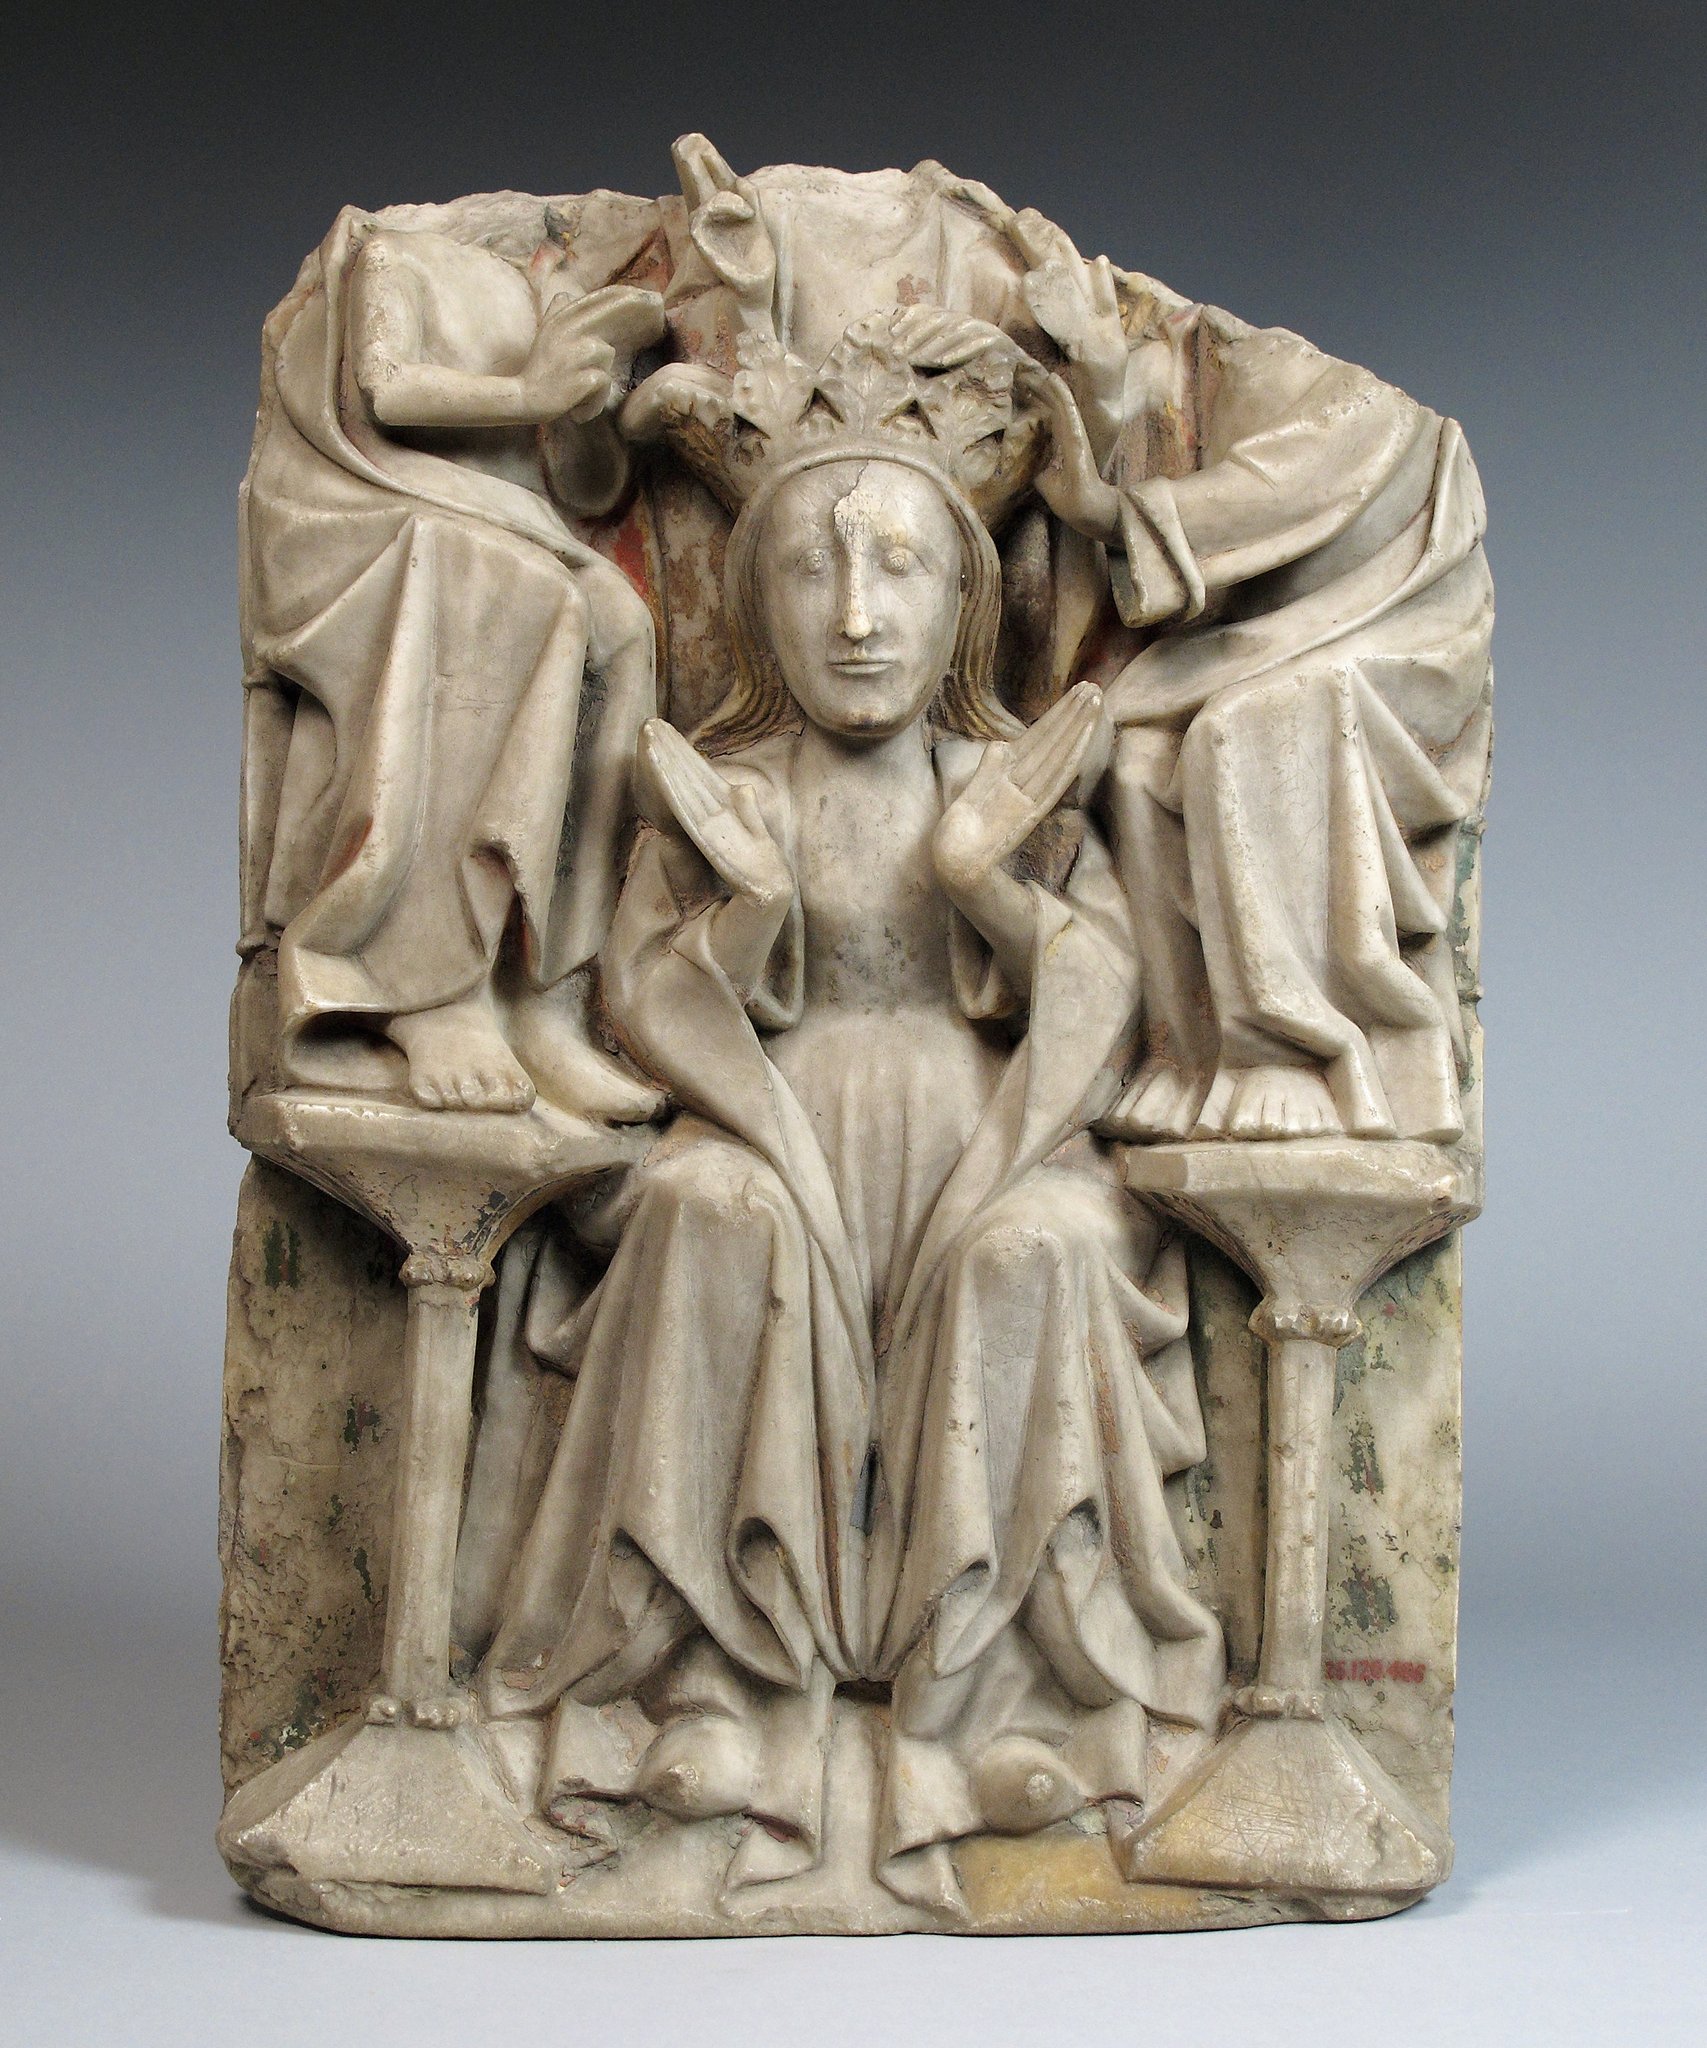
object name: relief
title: Coronation of the Virgin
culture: british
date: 1460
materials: alabaster, paint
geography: england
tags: virgin mary